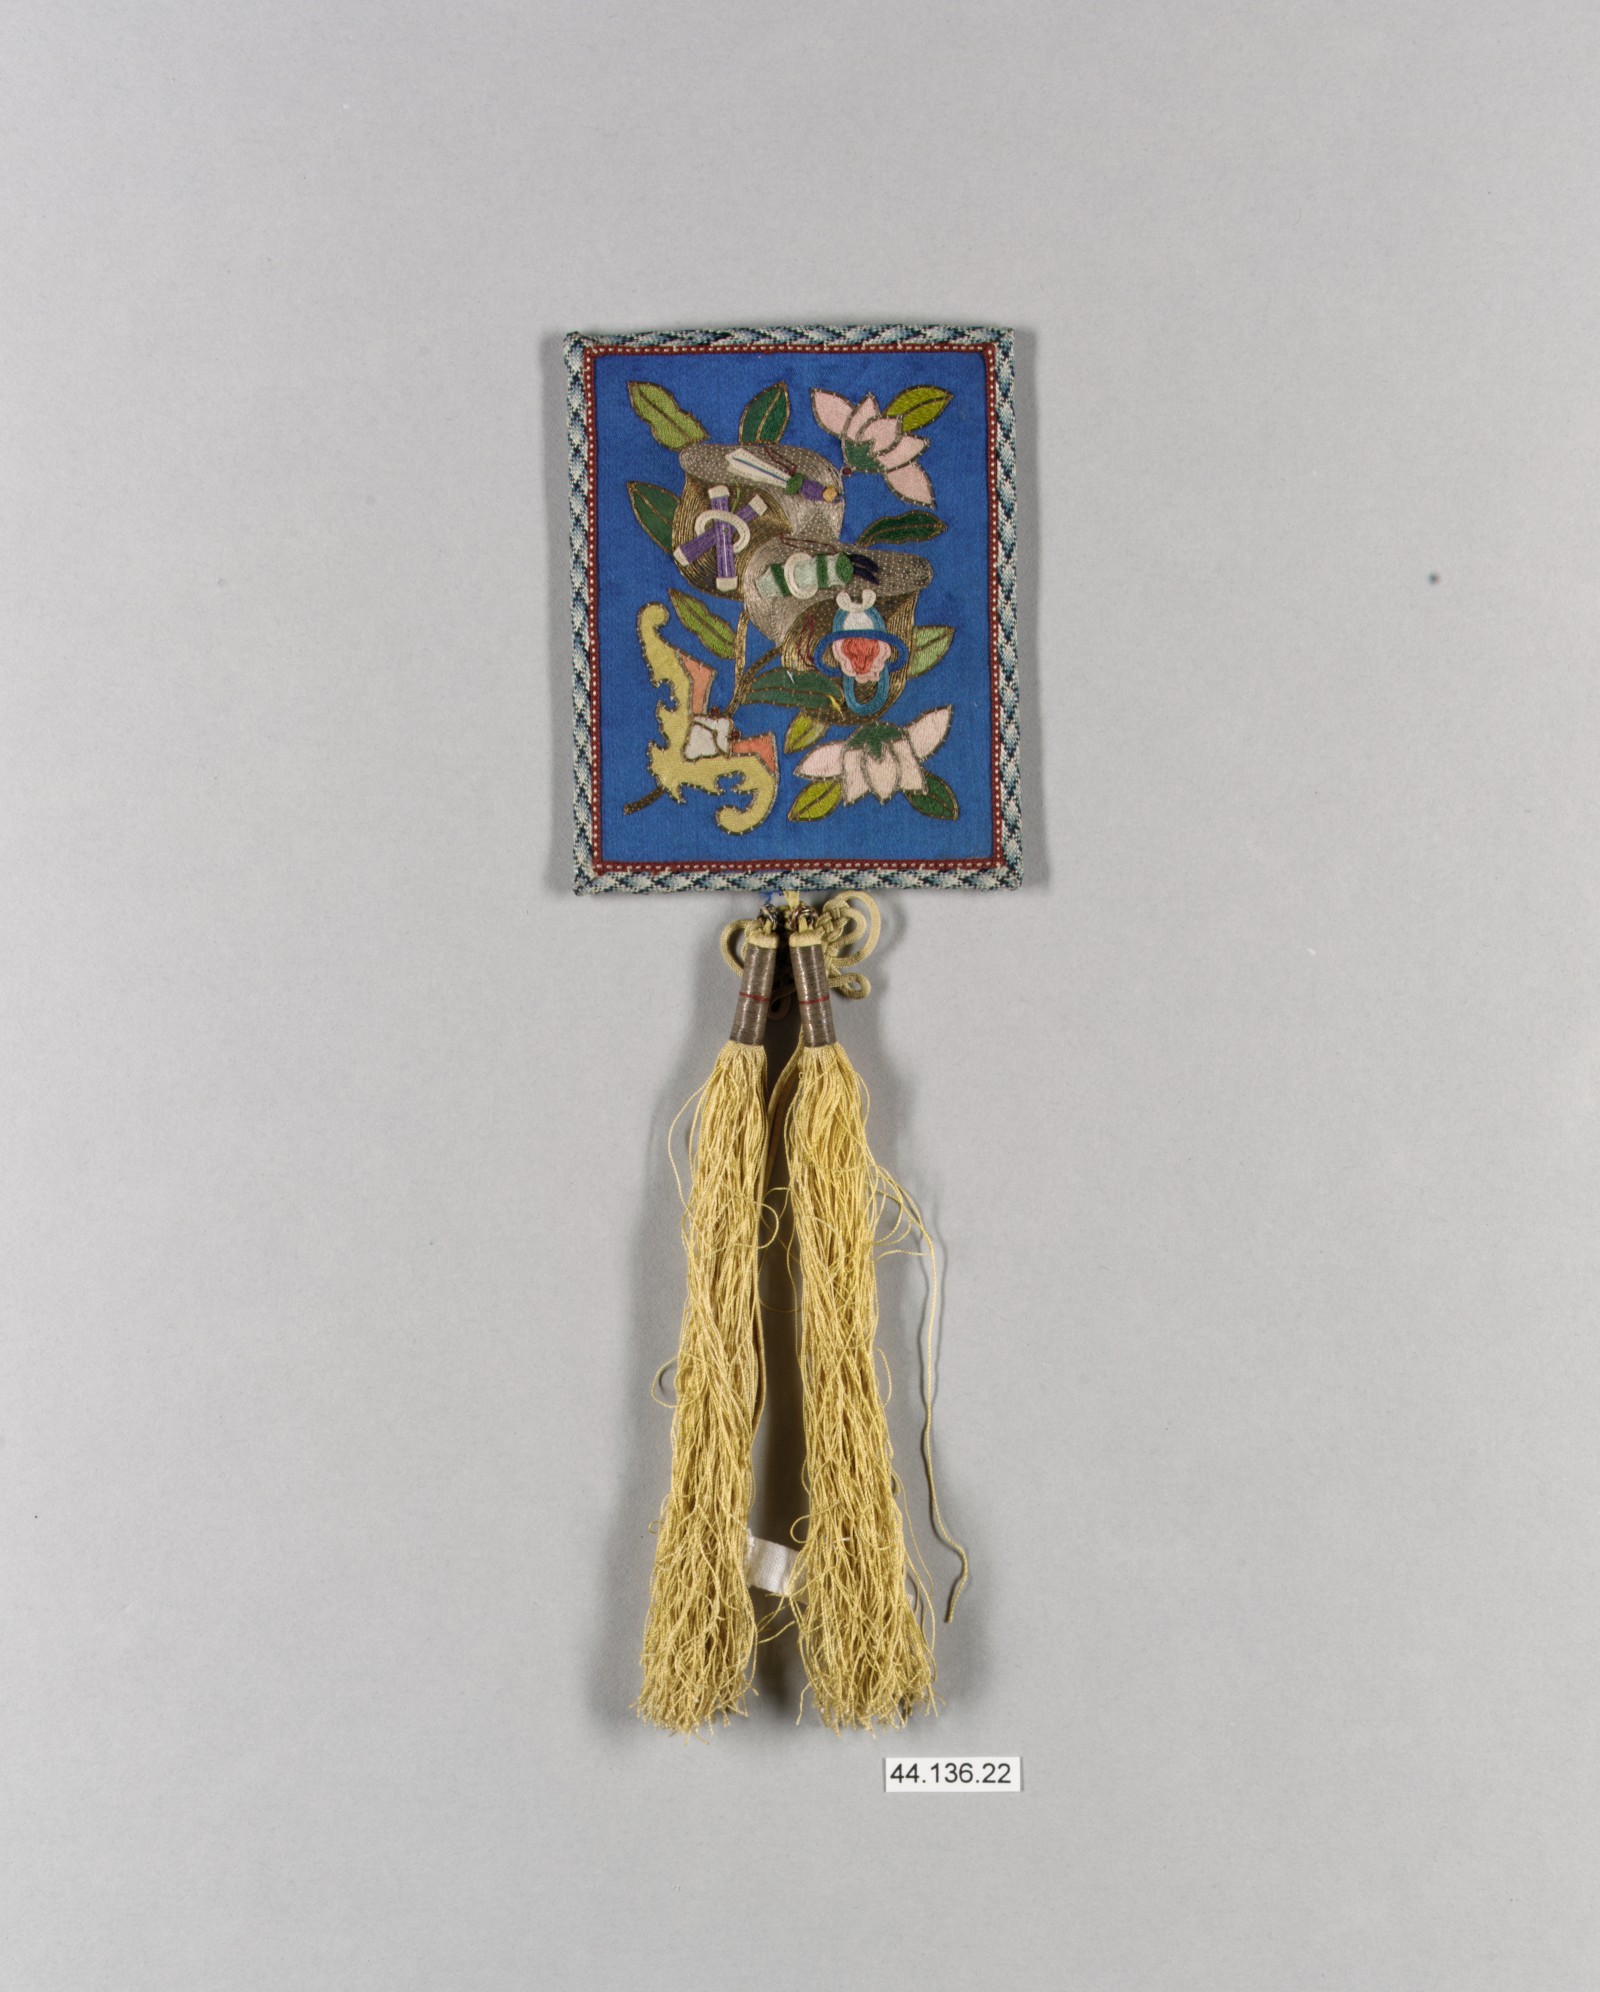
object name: mirror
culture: chinese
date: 1801-1900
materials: glass, metal thread, silk